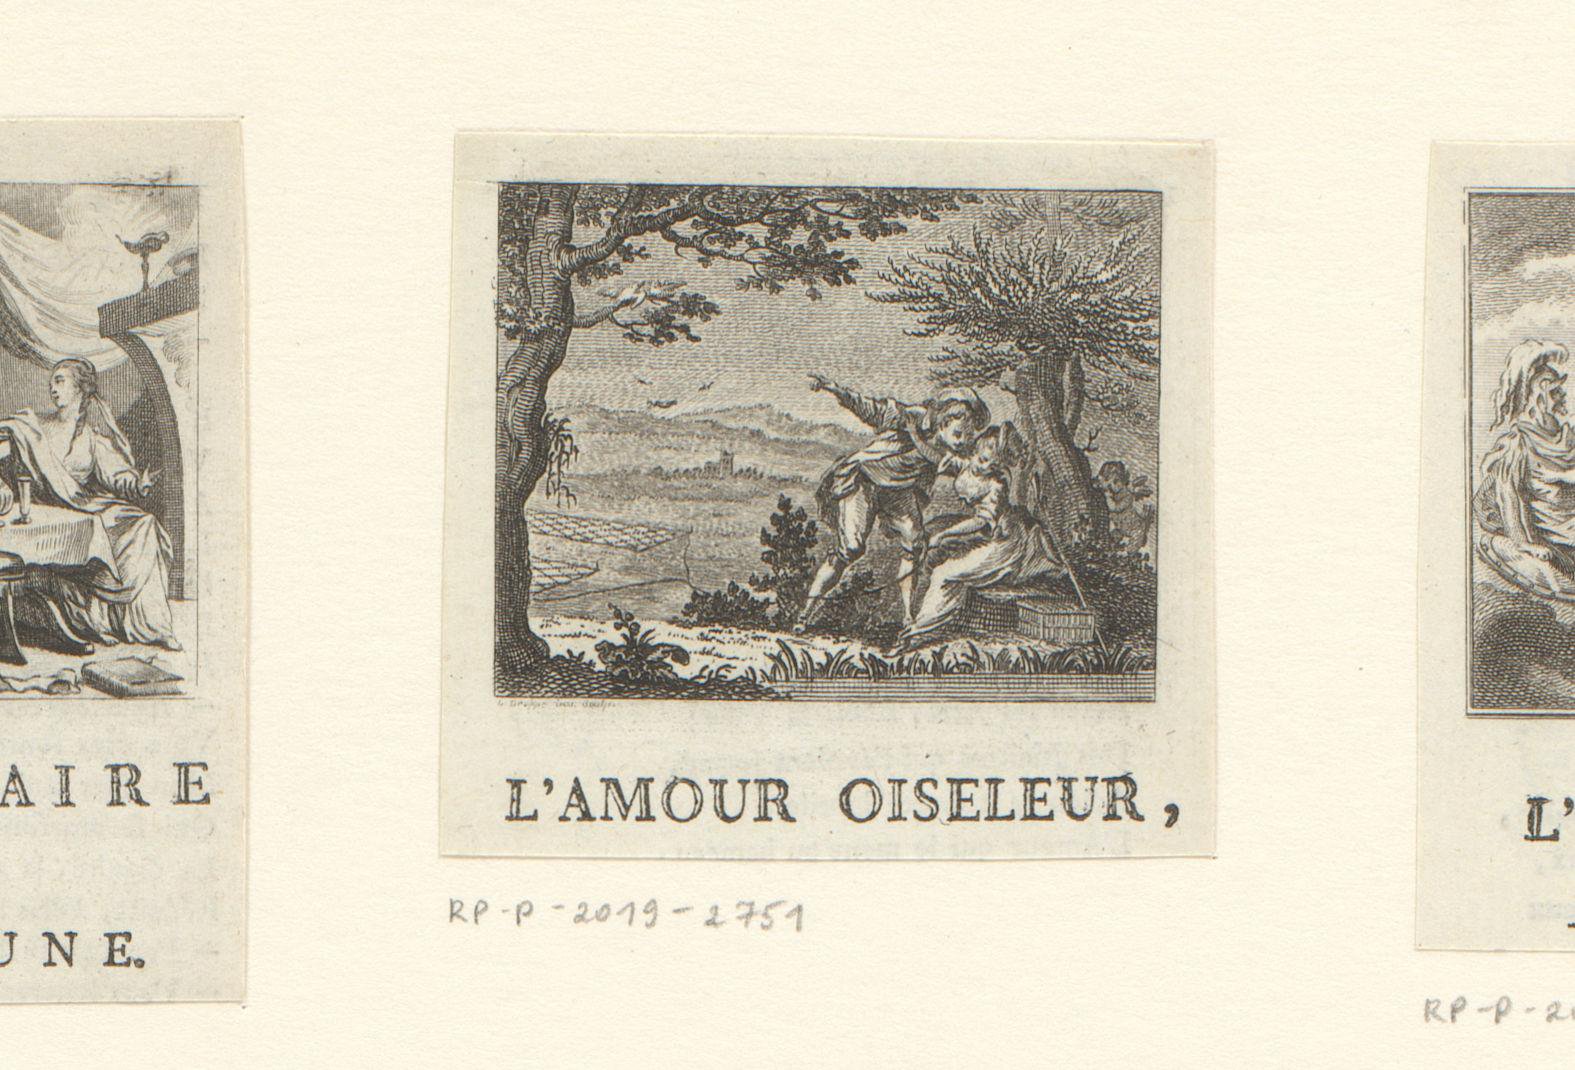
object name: book illustration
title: Tuin met verliefd koppel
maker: Anonymous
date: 1763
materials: paper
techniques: engraving, etching, letterpress printing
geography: france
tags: garden, couple of lovers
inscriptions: collector's mark: Lugt 2228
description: Mogelijk prent uit: Grecourt, Jean Baptiste Joseph Willart de. Oeuvres diverses de M. de Grécourt, nouvelle édition, augmentée d'un grand nombre de pièces, revus sur les originales et du Philotanis. Amsterdam: s.n., 1763.